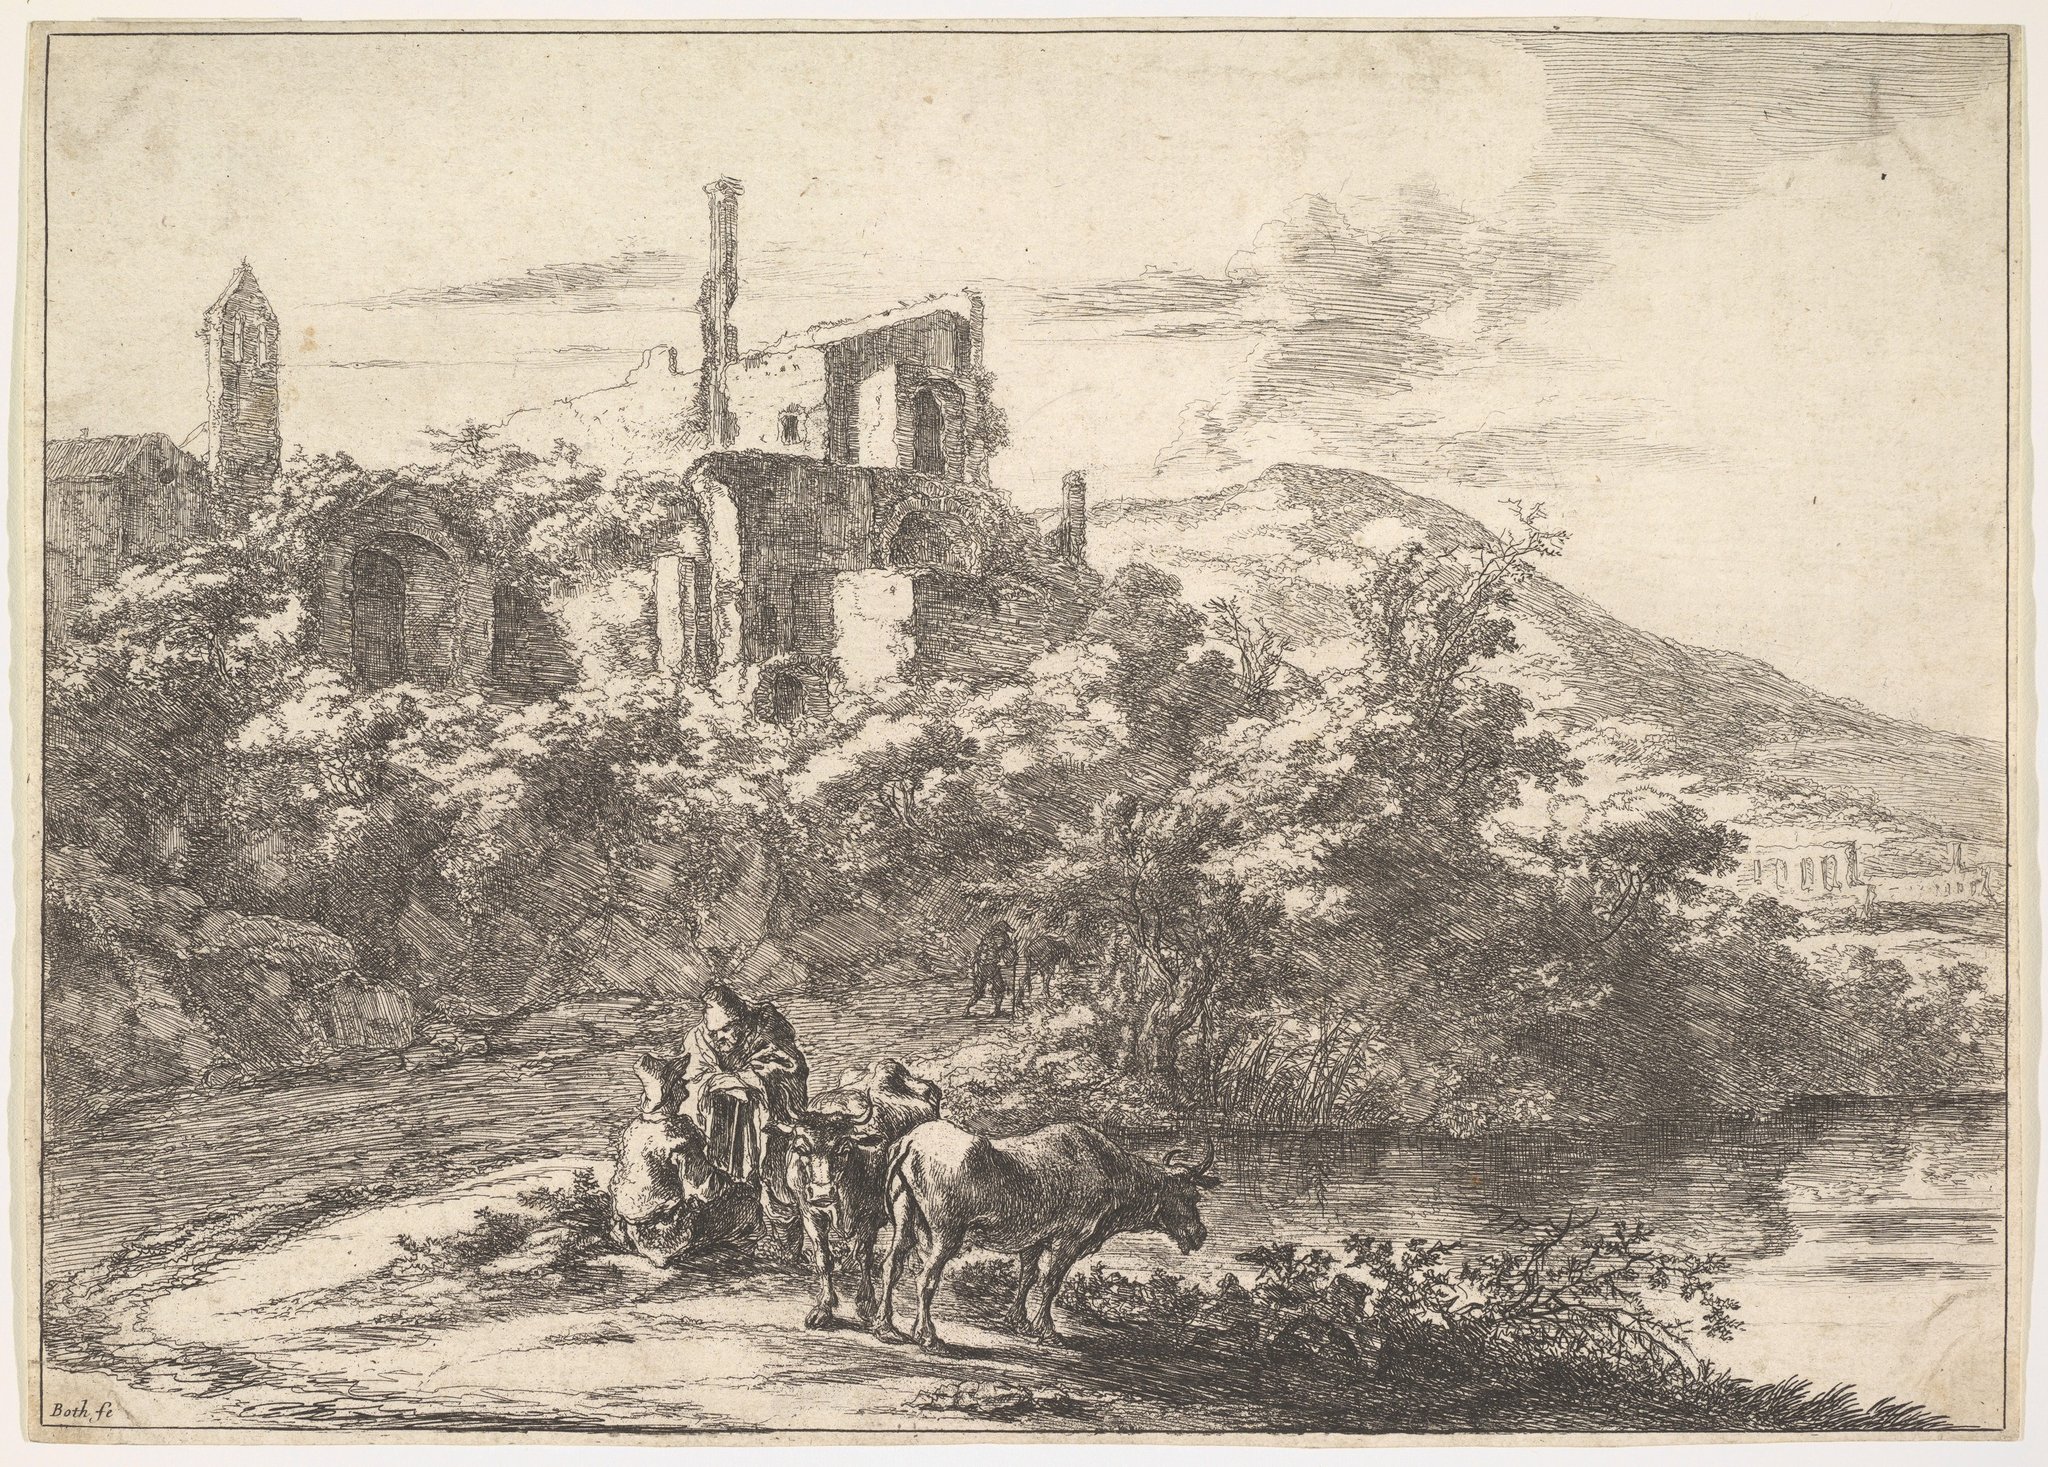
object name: print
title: Les Deux Vaches Au Bord De L'Eau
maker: jan both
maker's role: artist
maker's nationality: dutch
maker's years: 1618-1652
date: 1620-1652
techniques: engraving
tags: cows,landscapes